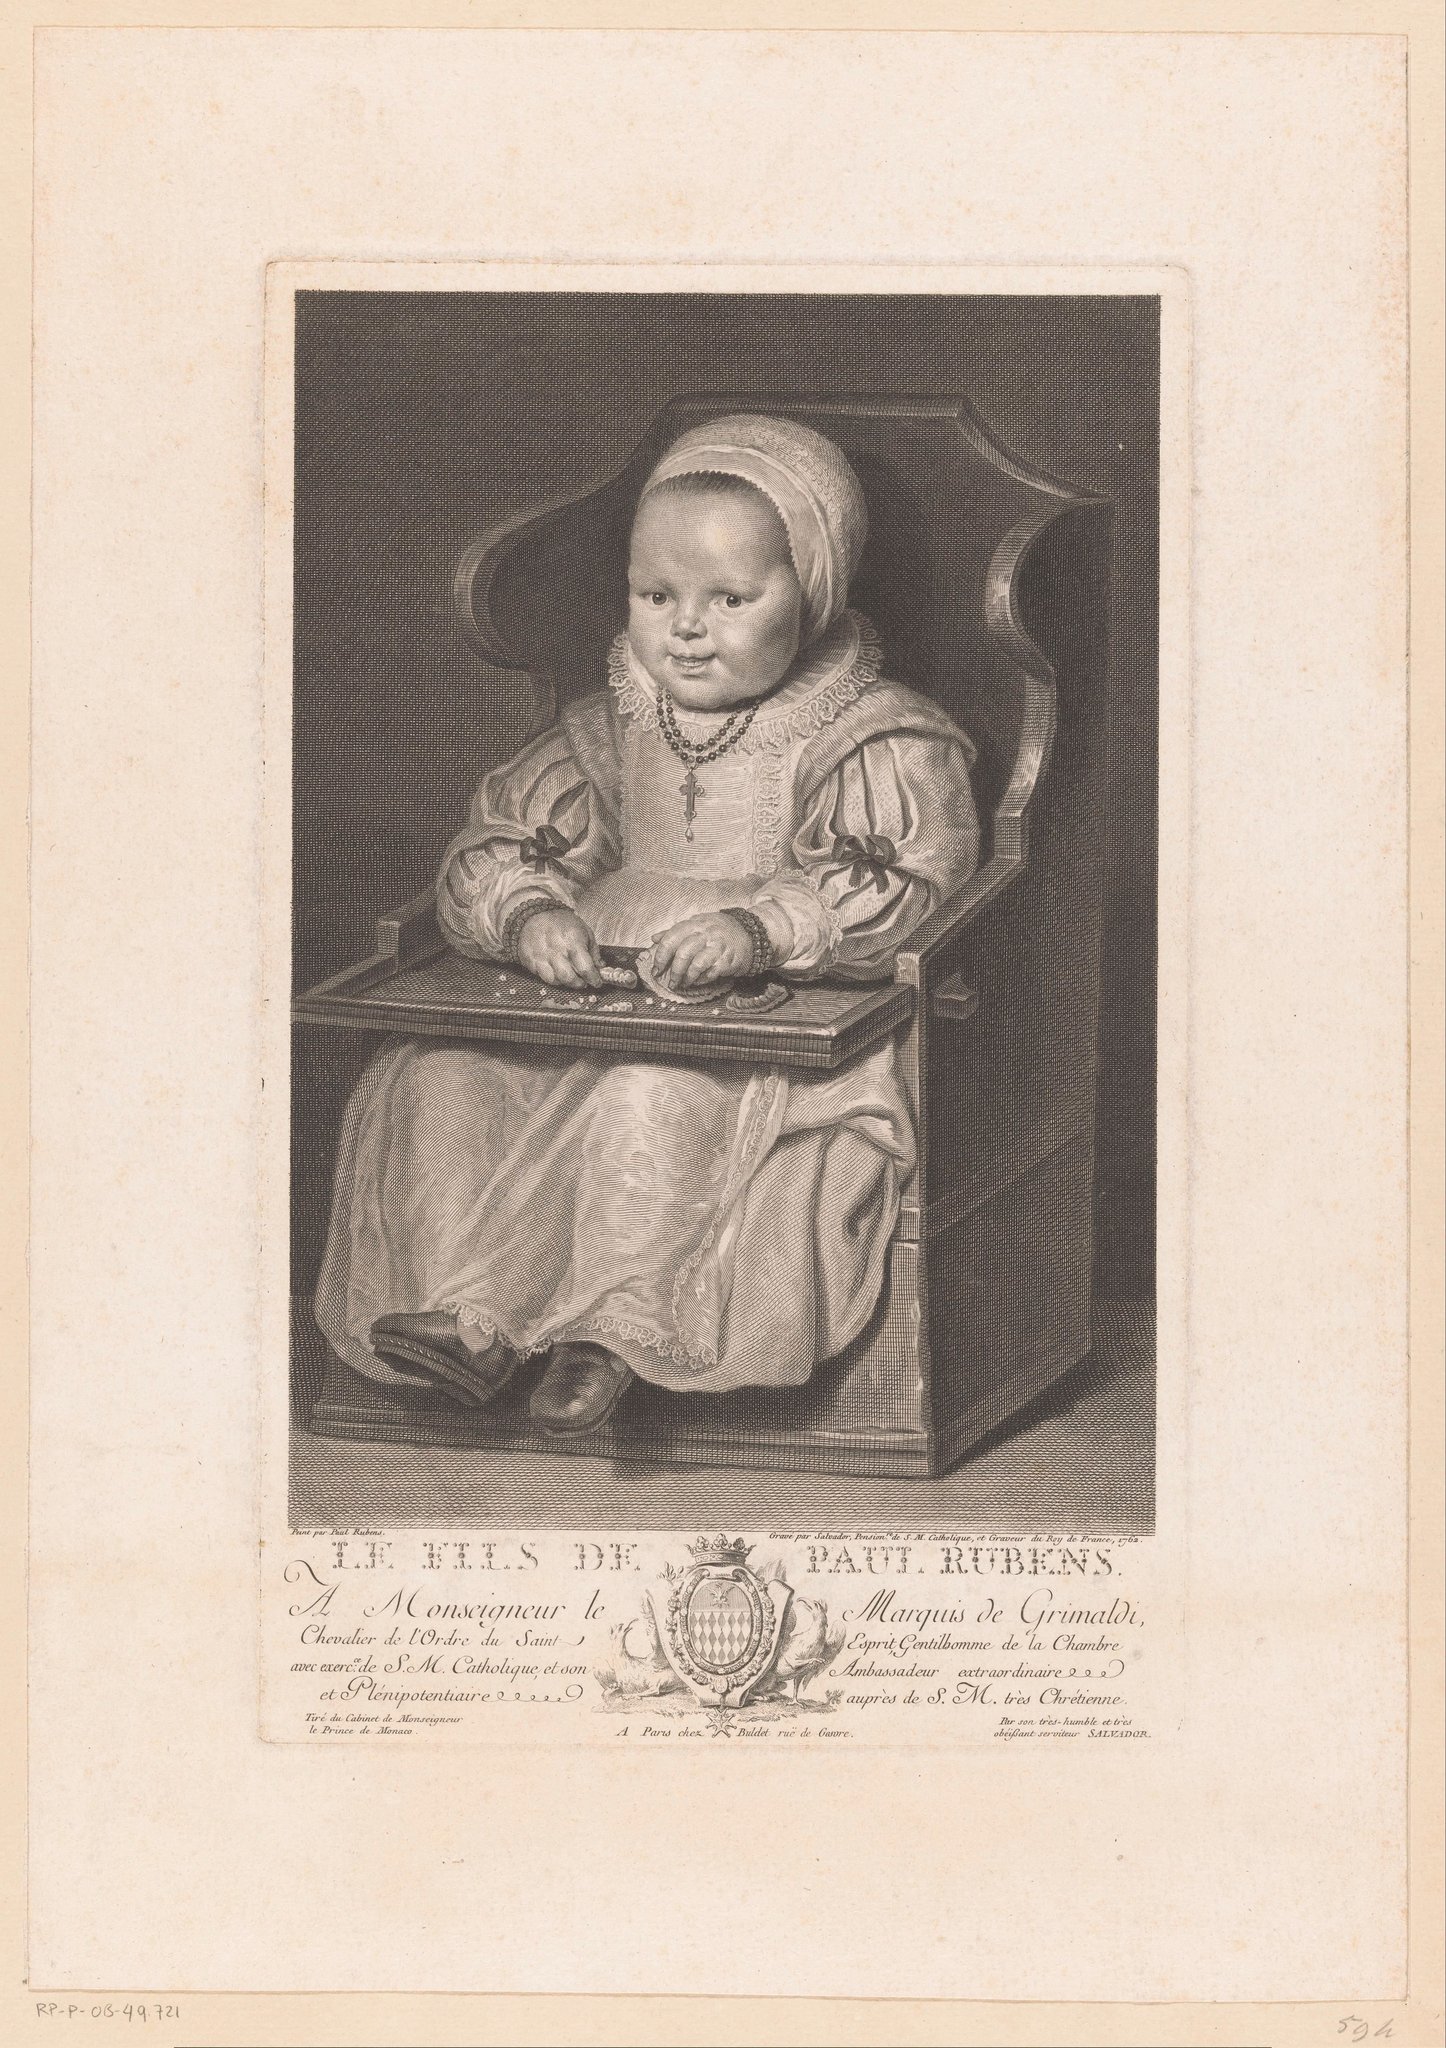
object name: print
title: Zoon van Rubens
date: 1762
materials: paper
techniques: engraving, etching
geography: paris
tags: baby-chair, historical persons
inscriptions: collector's mark: Lugt 240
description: Prent naar het schilderij door Cornelis de Vos van zijn dochter Susanna. Het schilderij bevond zich voorheen in de collectie van de prins Grimaldi te Monaco en bevindt zich heden ten dage in het Städel Museum te Frankfurt am Main.